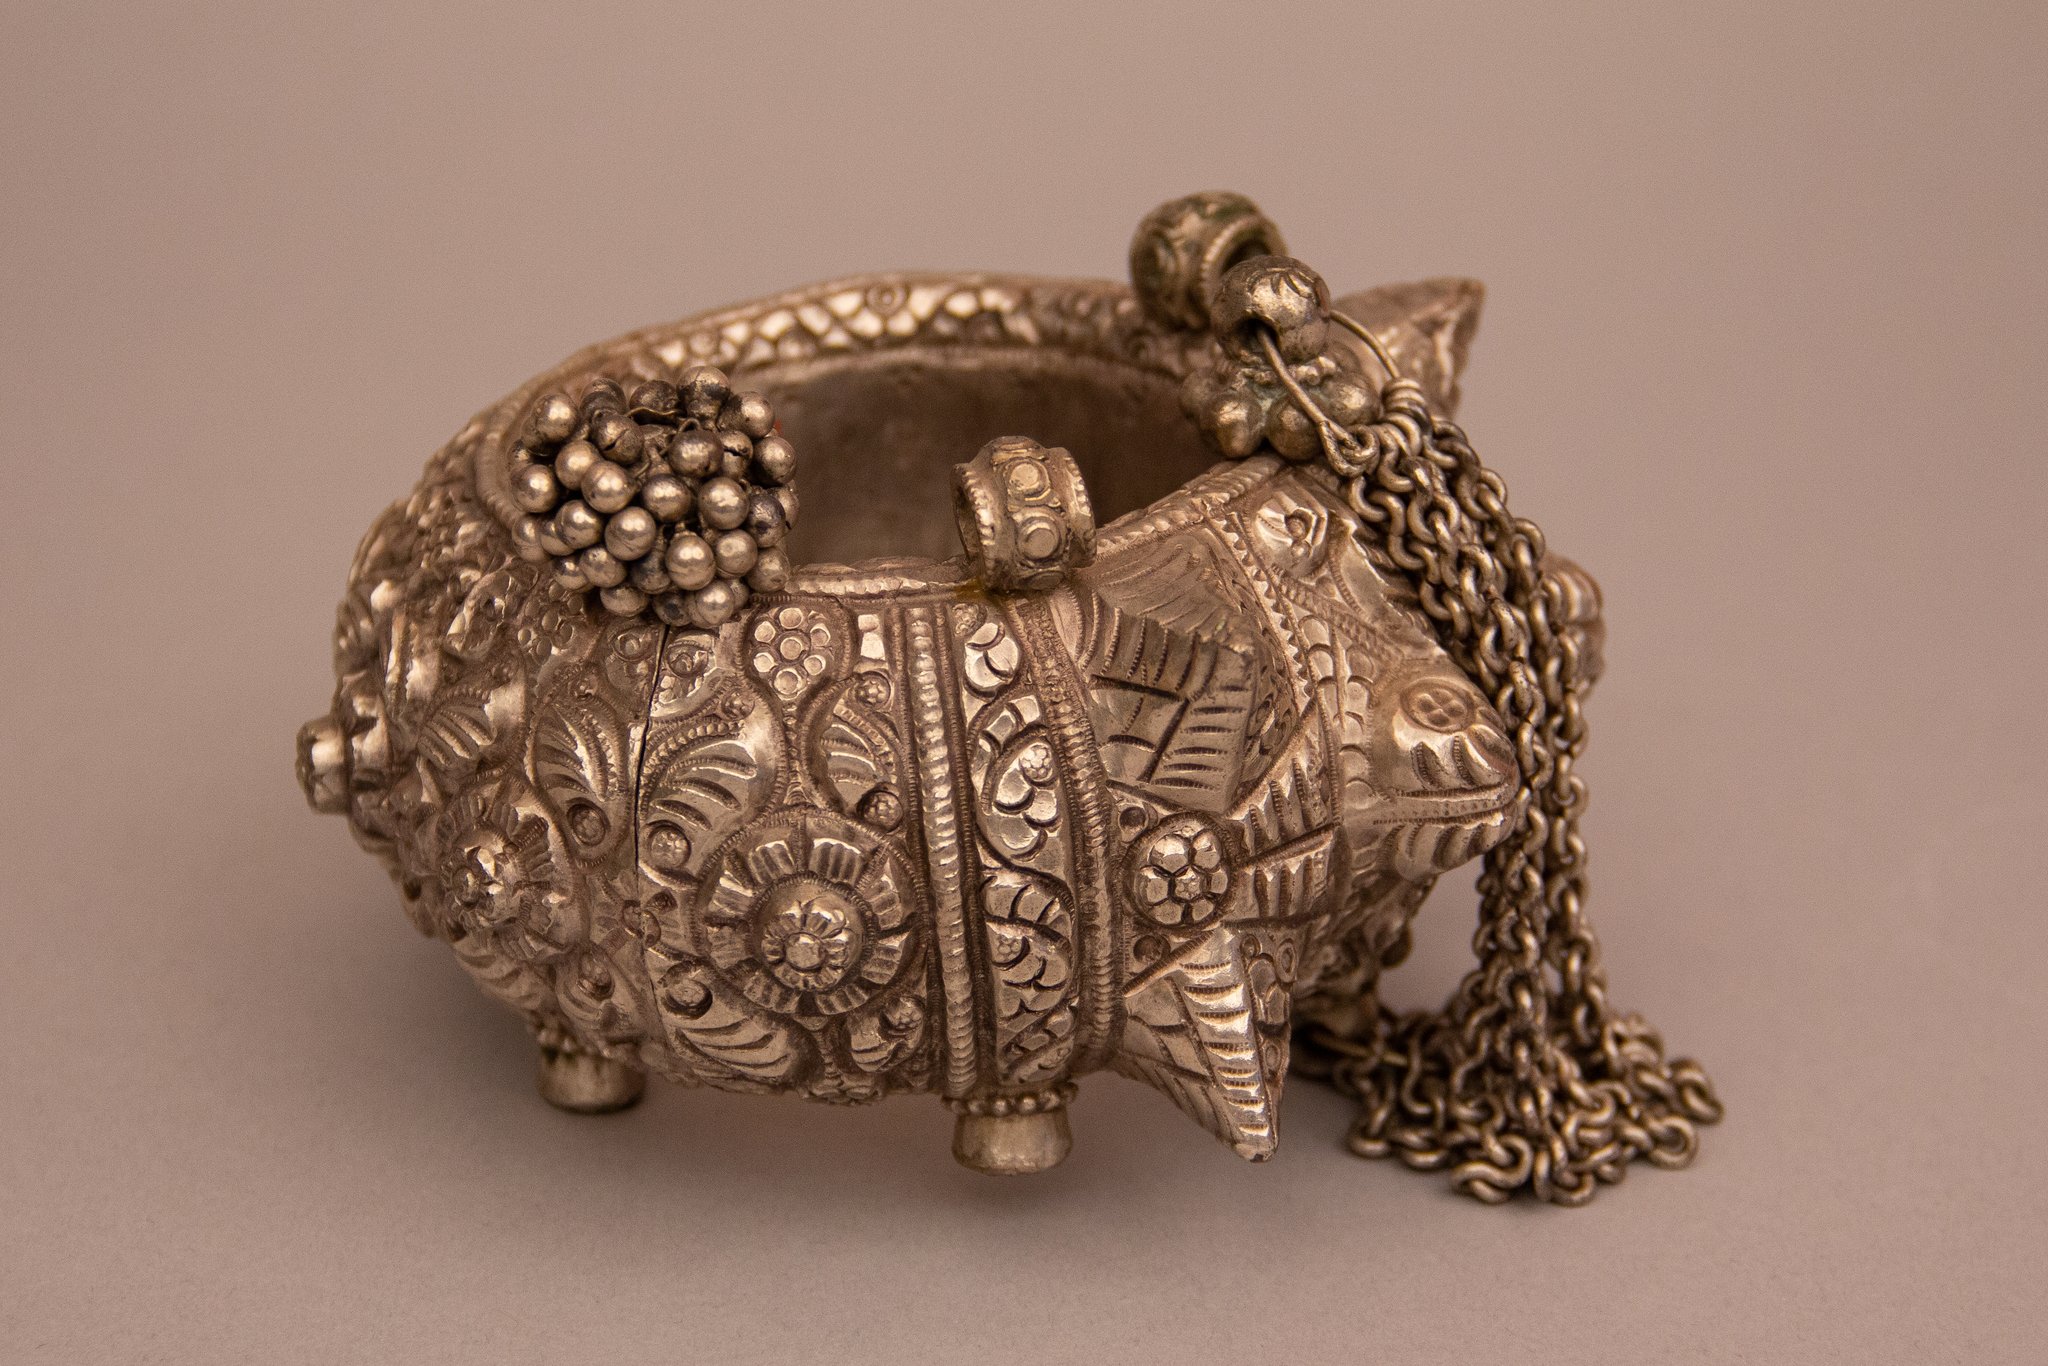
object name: anklet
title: Anklet, One of a Pair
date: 1801-1900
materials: silver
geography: central india